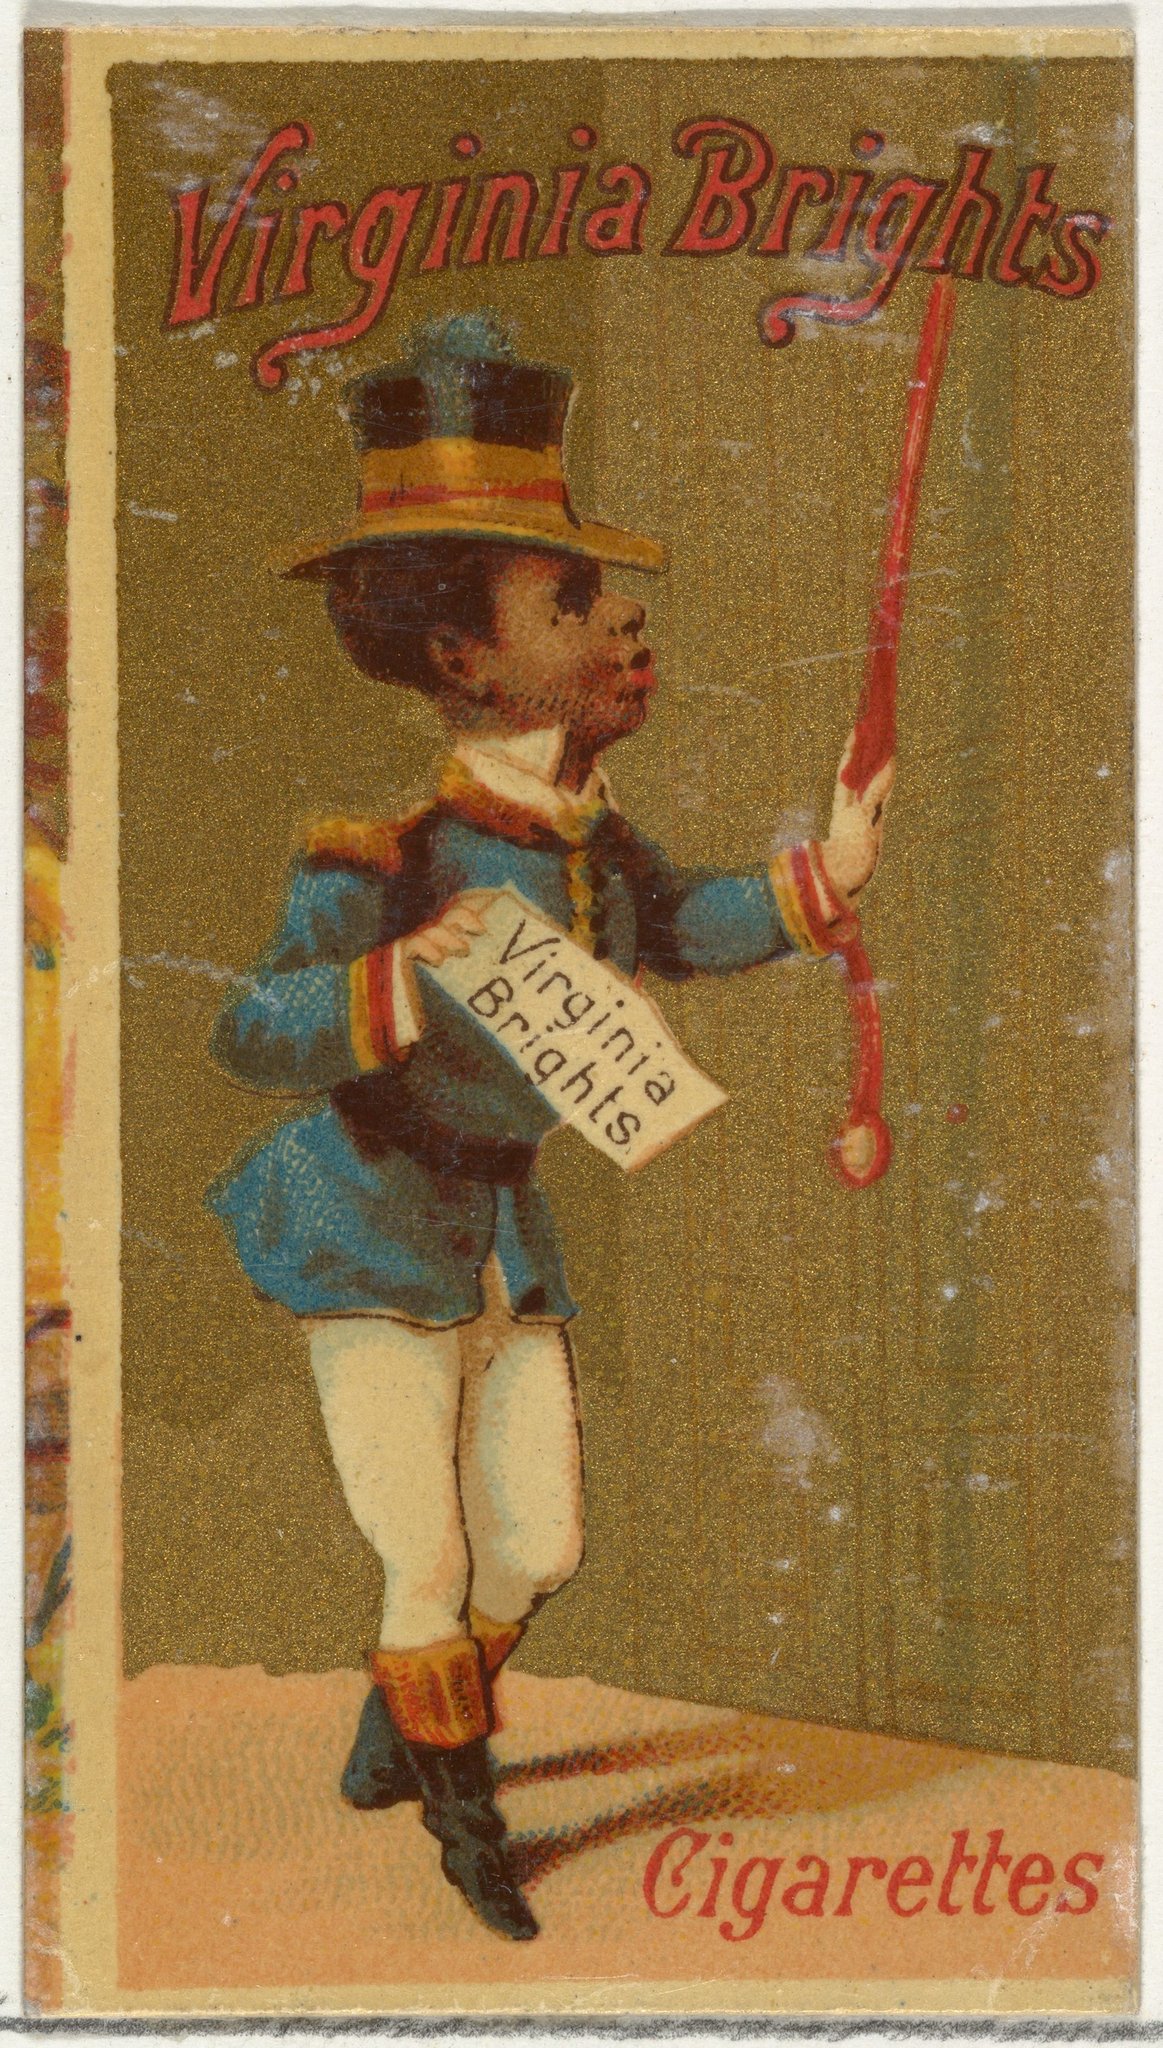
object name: print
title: Caricatured Figure from the Girls and Children series (N64) promoting Virginia Brights Cigarettes for Allen & Ginter brand tobacco products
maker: allen & ginter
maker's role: publisher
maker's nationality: american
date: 1886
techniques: color lithograph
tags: boys